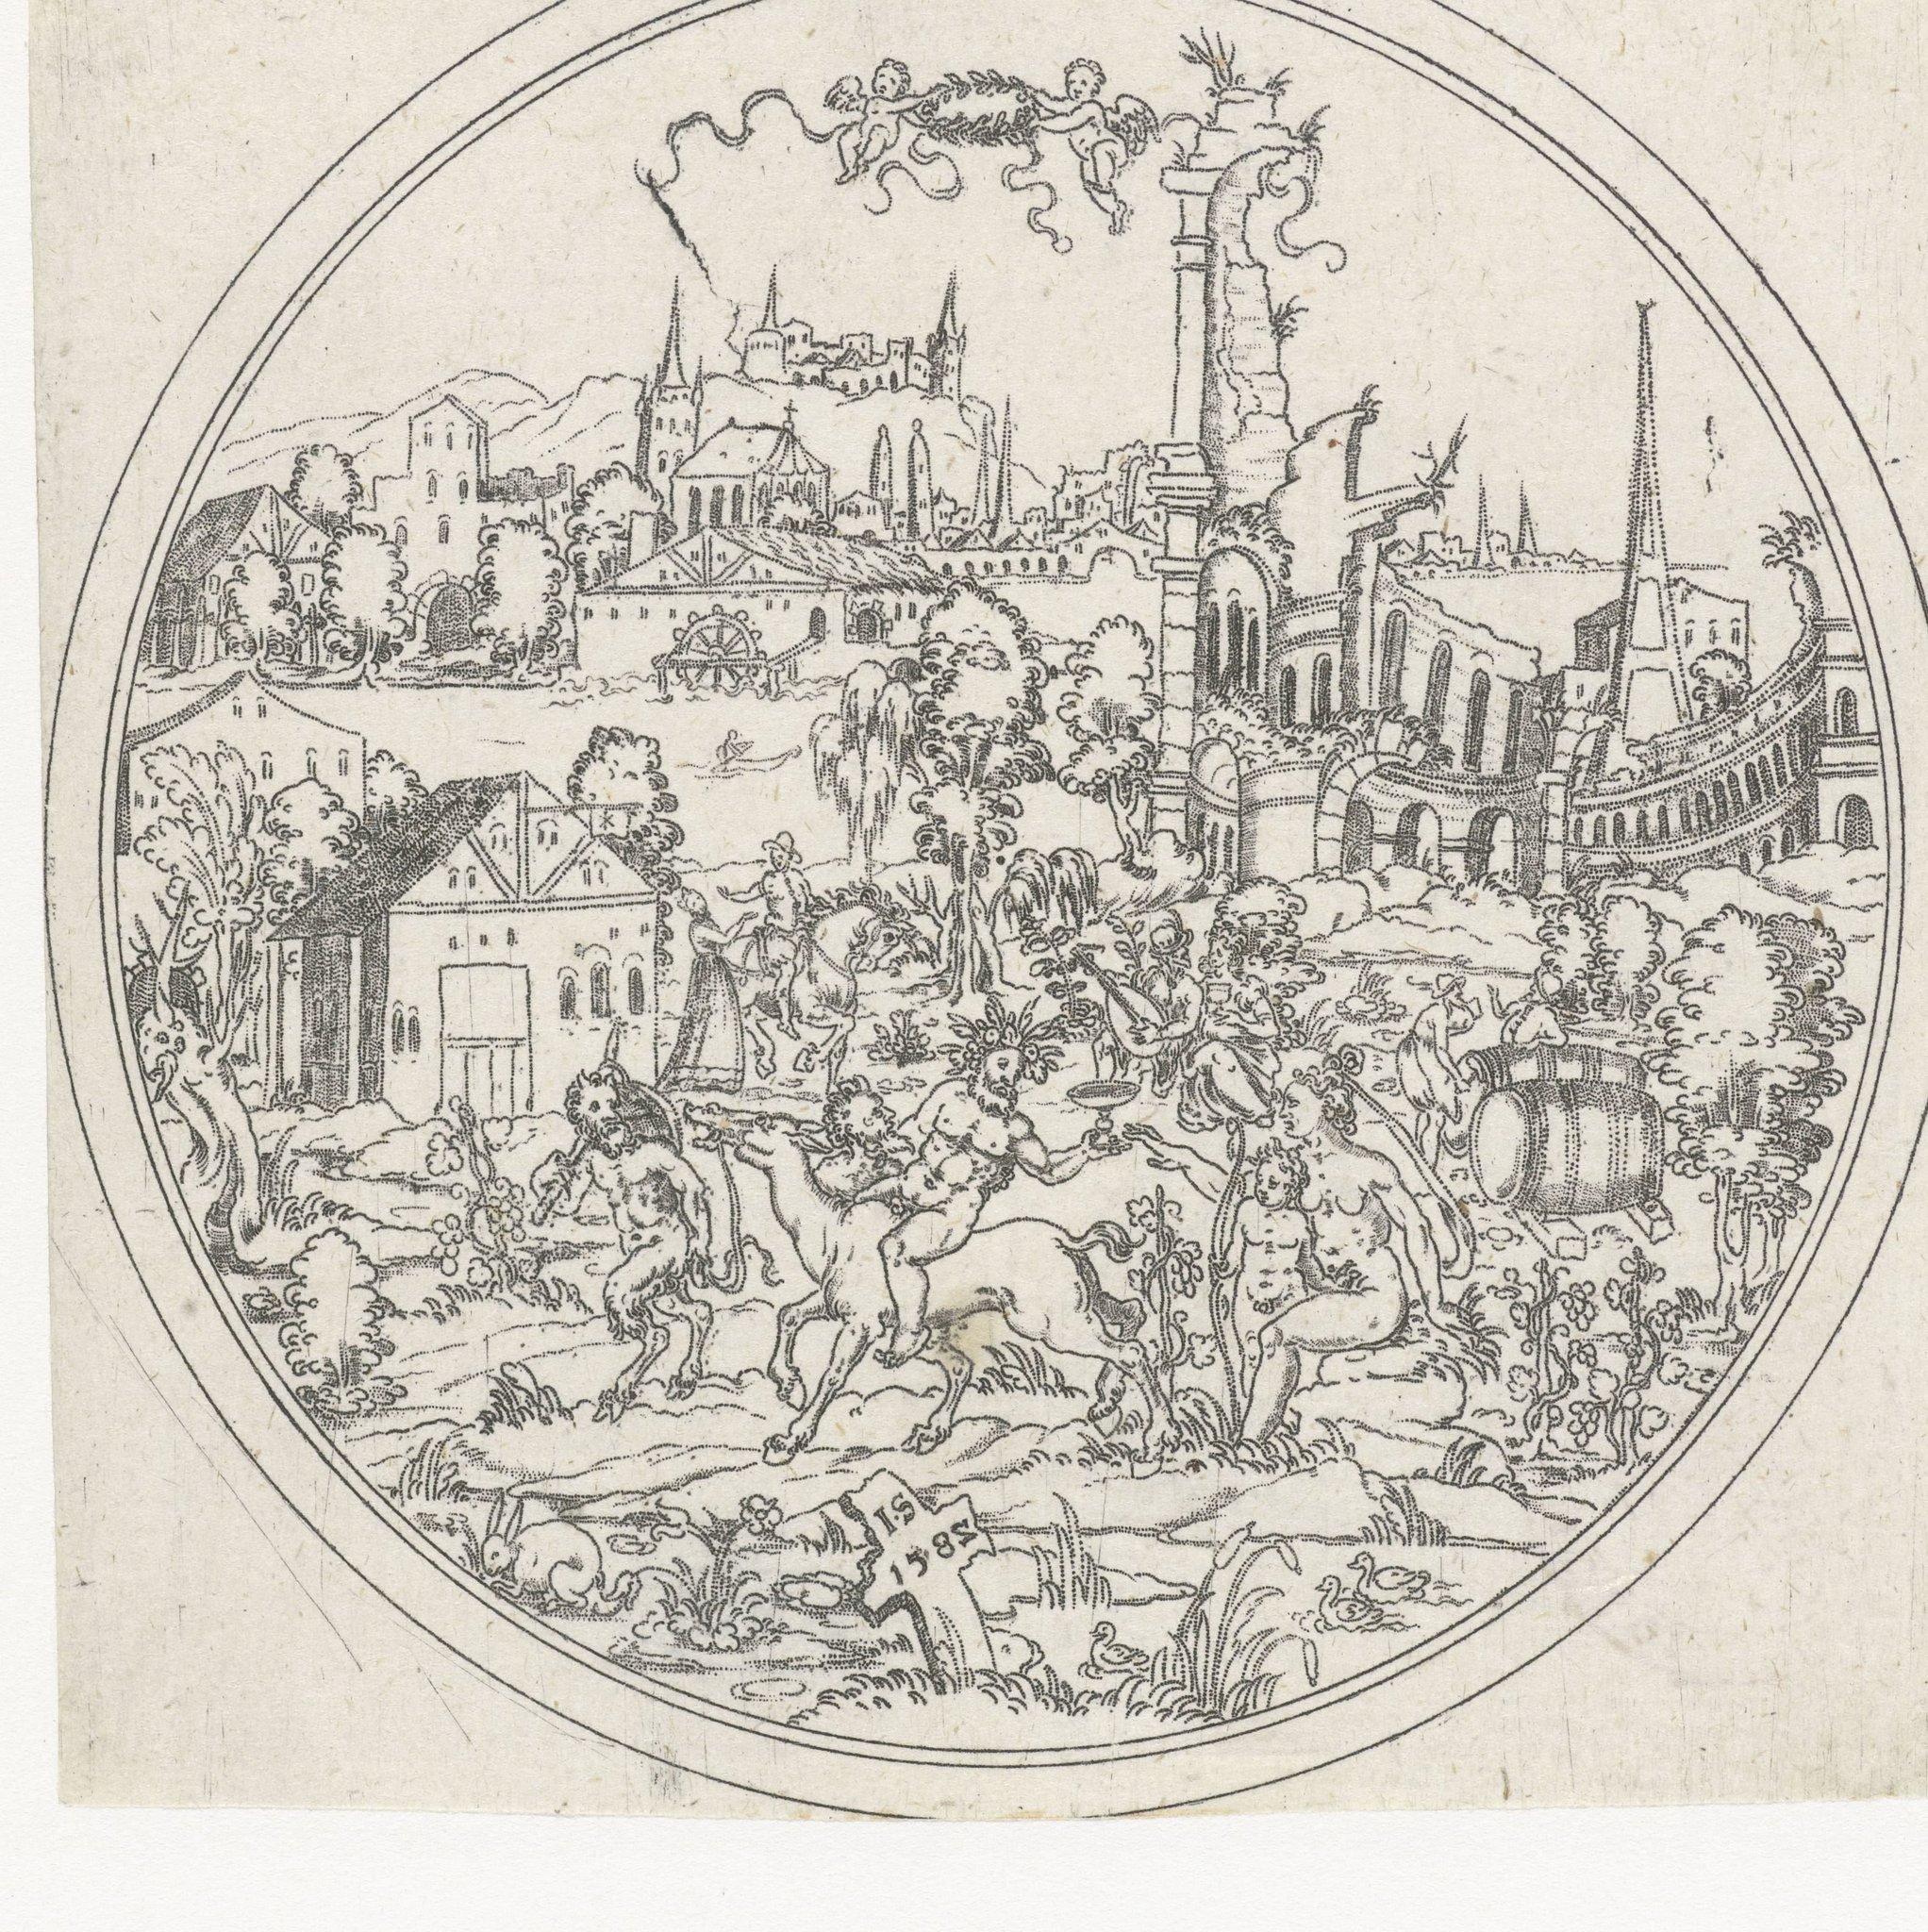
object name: print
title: Bodems van schalen: landschappen met bijbelse en mythologische voorstellingen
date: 1572-1582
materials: paper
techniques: engraving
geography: germany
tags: (story of) silenus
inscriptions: collector's mark: Lugt 240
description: Silenus, rijdend op een ezel en vergezeld door saters. In de lucht zweven twee putti met een lauwerkrans. Uit serie van 8 bladen?